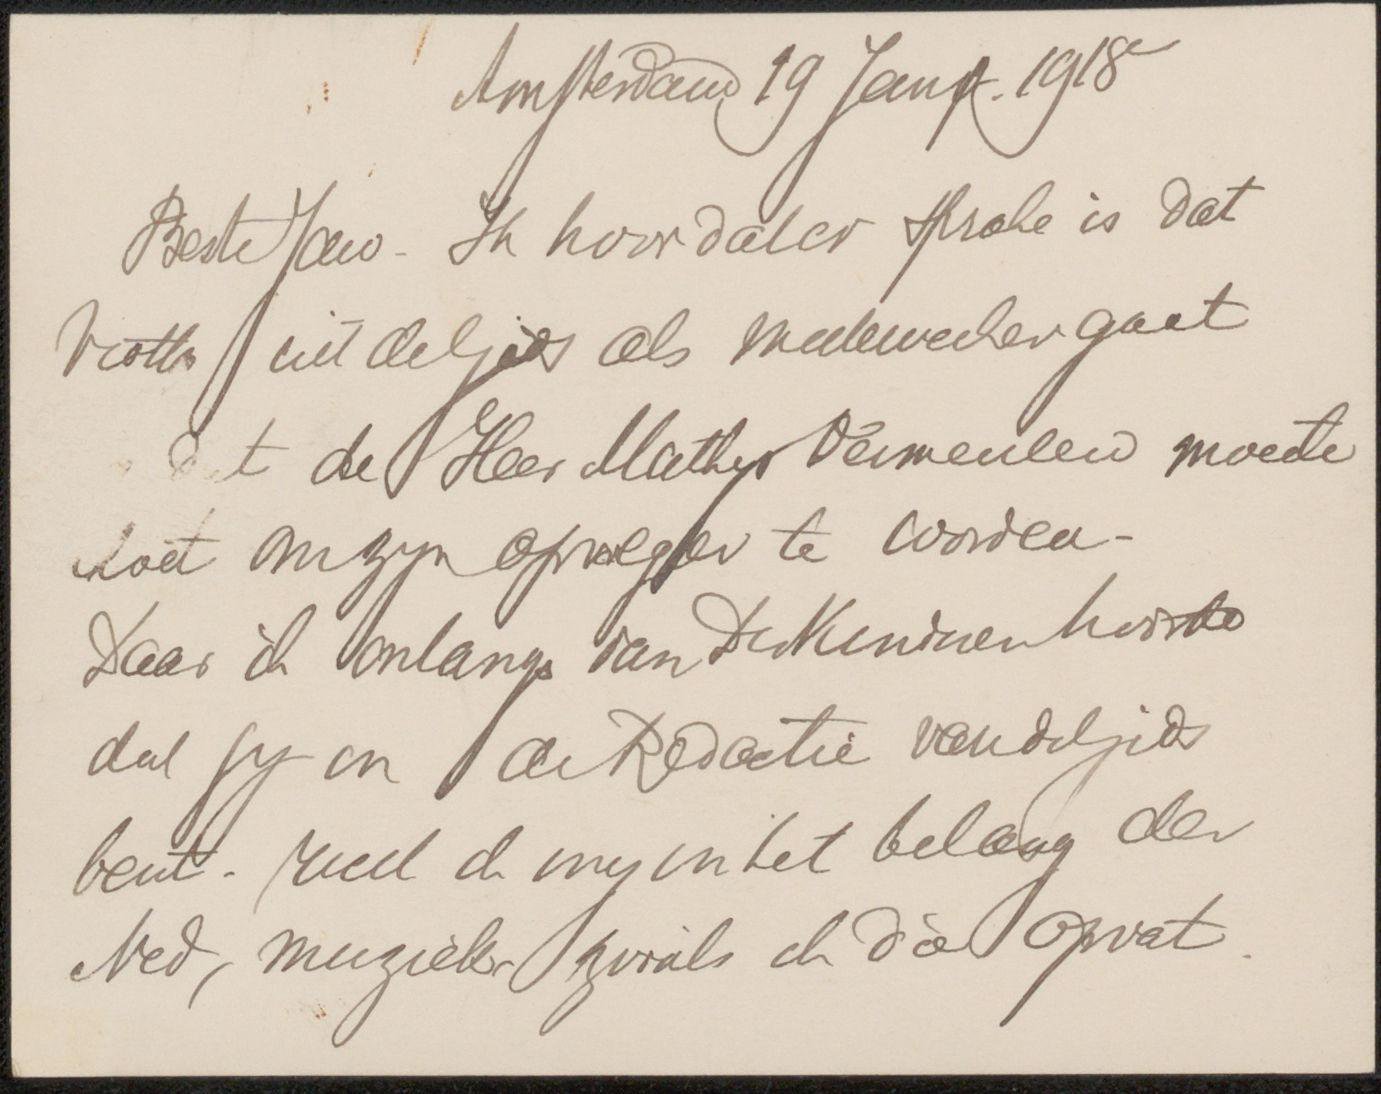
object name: letter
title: Brief aan Jan Veth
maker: alphons diepenbrock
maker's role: componist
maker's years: 1862-1921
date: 1918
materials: cardboard, ink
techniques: pen, writing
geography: amsterdam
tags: dordrecht, painter, draughtsman, designer, jan veth, music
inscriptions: collector's mark: ‘RPK’